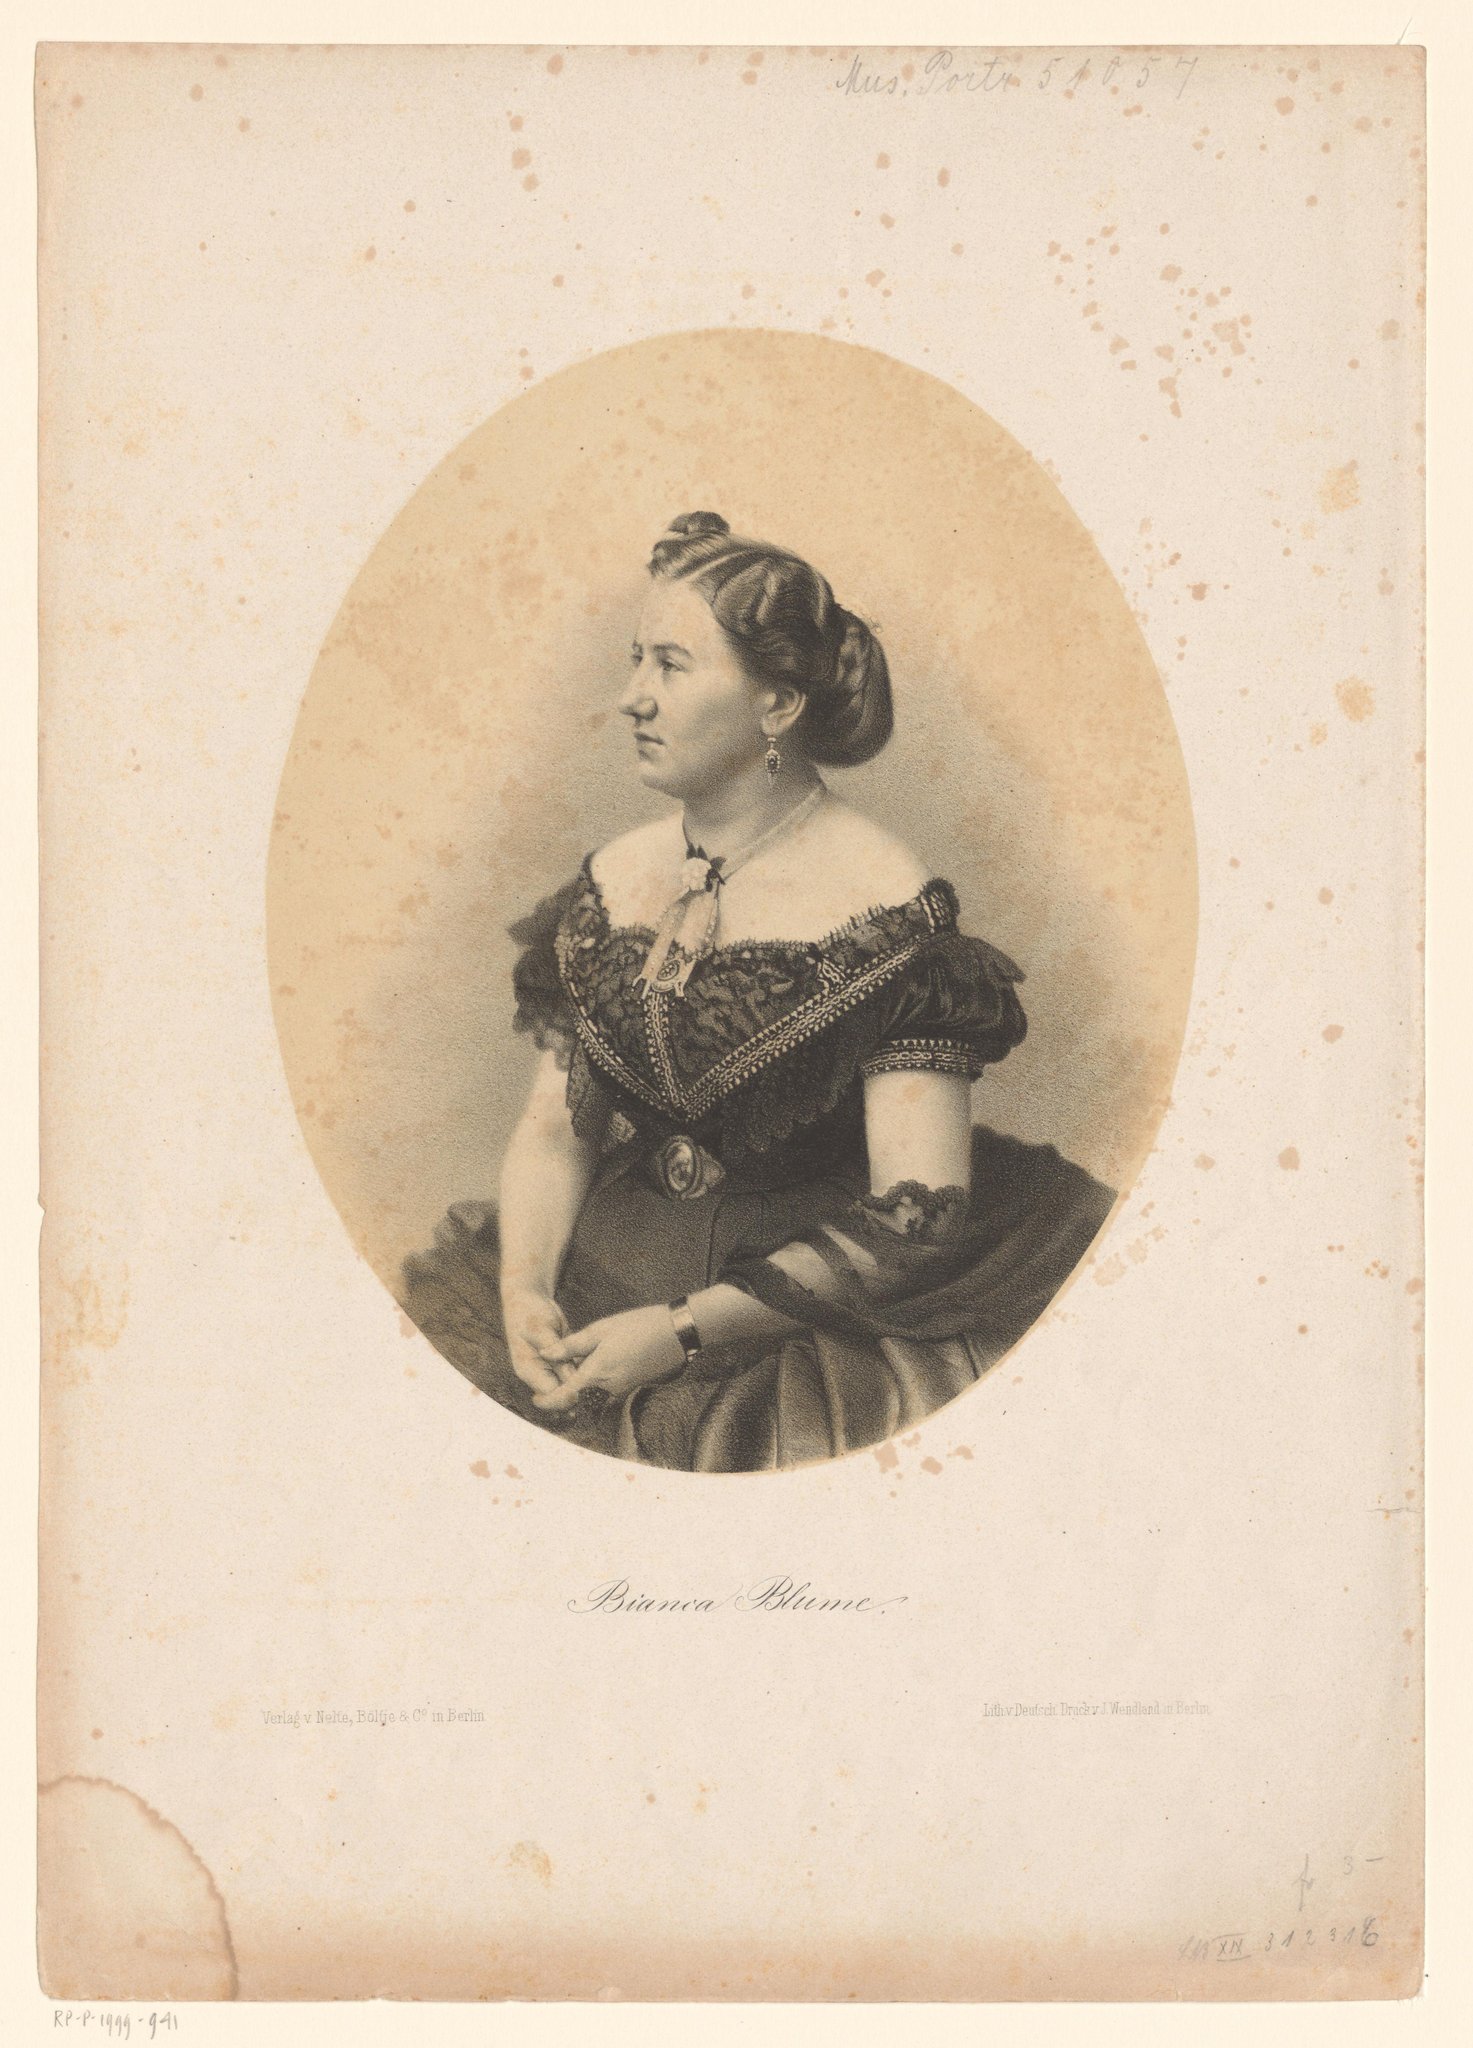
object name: print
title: Portret van Bianka Blume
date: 1870-1900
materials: paper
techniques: tone lithography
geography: berlin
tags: historical persons - bb - woman, female singer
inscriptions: collector's mark: ‘Franz Radestahl[?]’, collector's mark: Lugt 2228, collector's mark: Lugt 2760